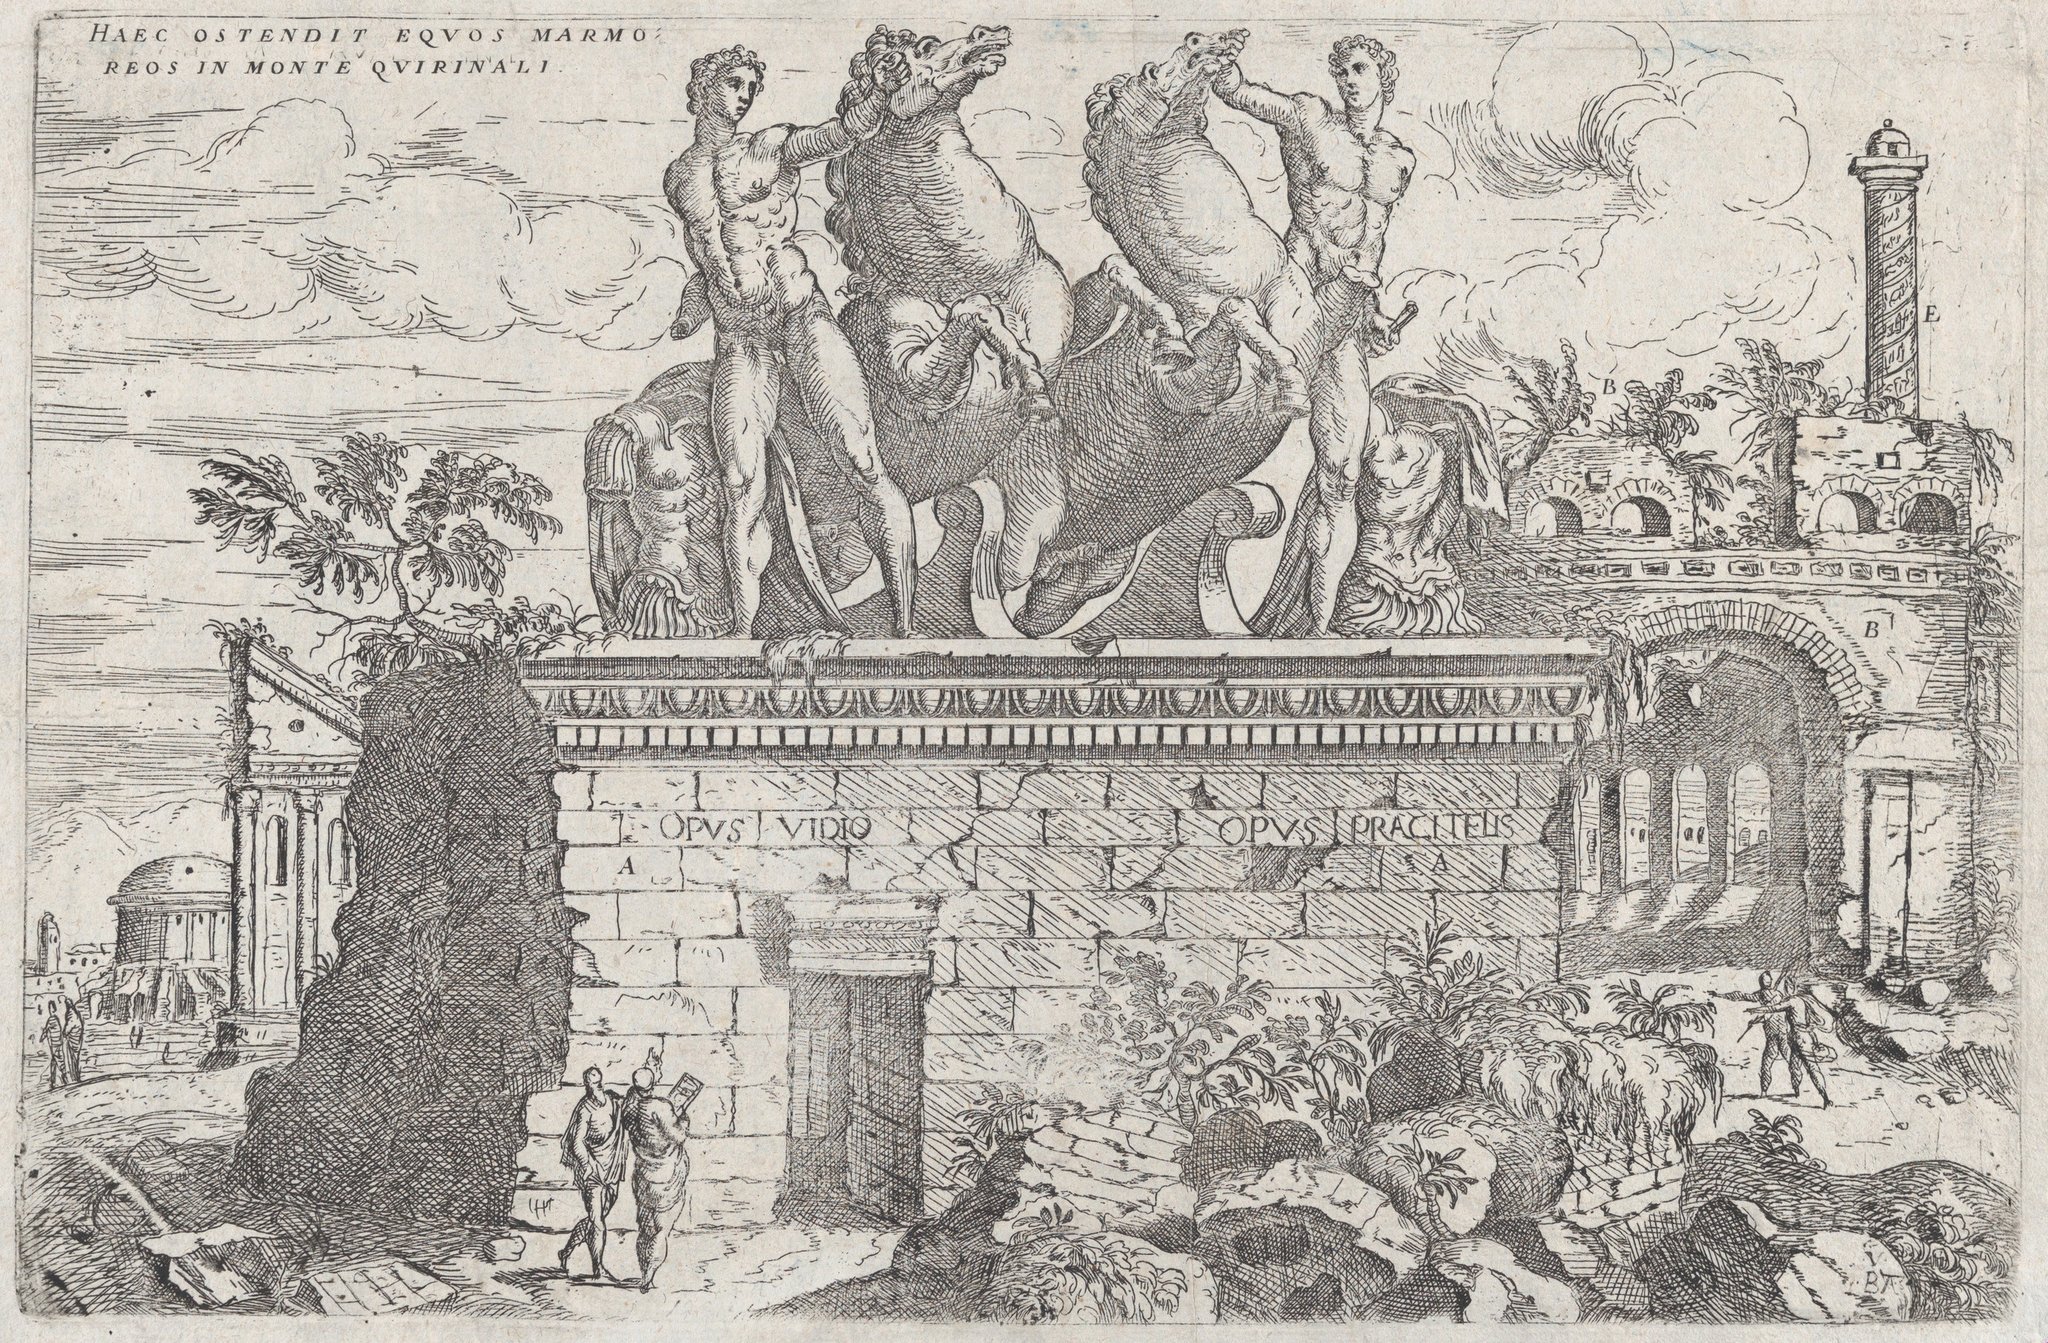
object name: print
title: Roman ruins with the horse tamers (Dioscuri) on the Quirinal Hill, plate 36 from "Discorsi Sopra L’Antichita di Roma"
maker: giovanni battista pittoni the elder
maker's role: artist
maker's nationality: italian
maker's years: 1520-1583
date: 1730-1760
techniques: etching